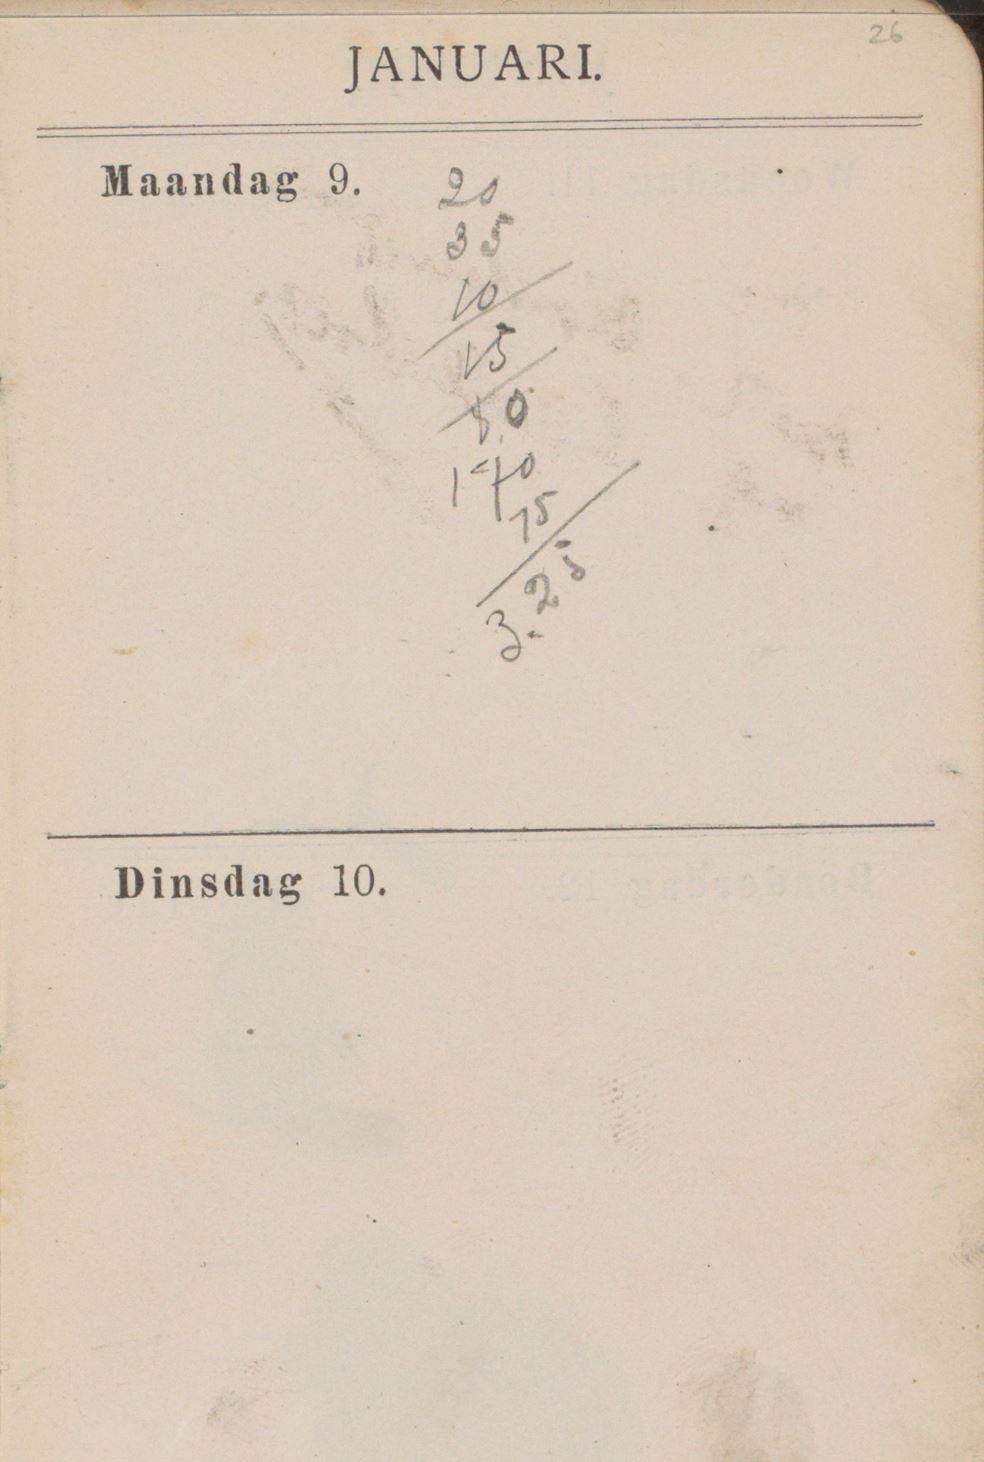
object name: sketchbook leaf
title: Annotaties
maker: george hendrik breitner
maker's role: draughtsman, painter, print maker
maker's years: 1857-1923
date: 1893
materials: paper, pencil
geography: amsterdam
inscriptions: annotation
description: Pagina 26 uit een als schetsboek gebruikte agenda met 108 bladen.